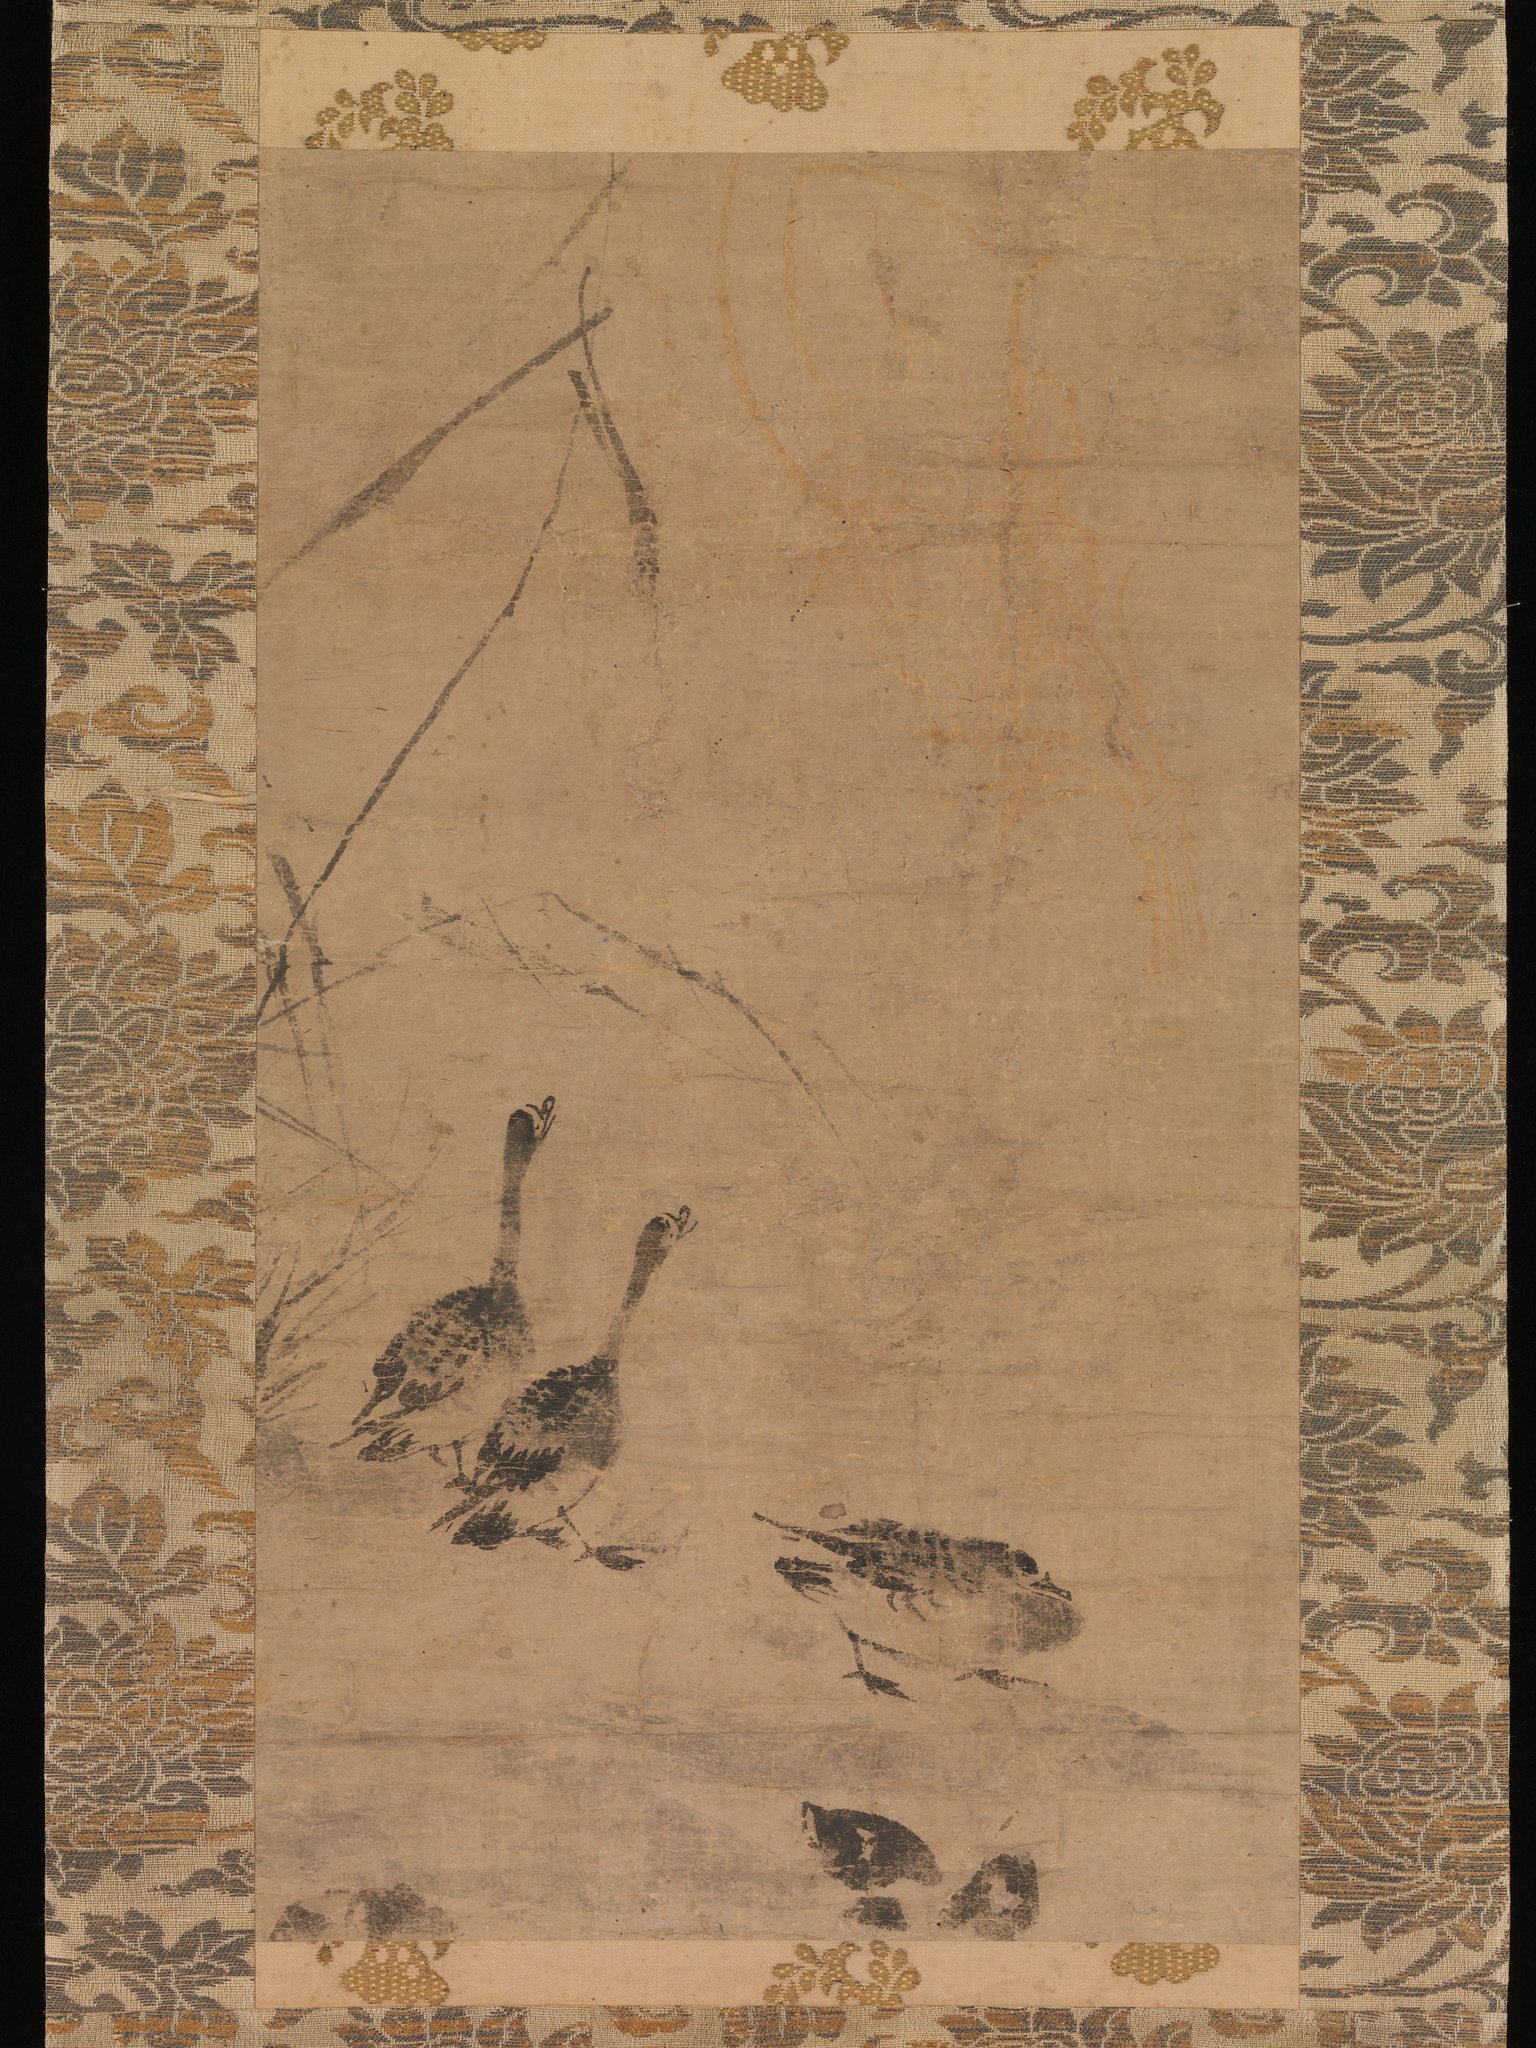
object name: hanging scroll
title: Geese and Reeds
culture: japanese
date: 1367-1400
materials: ink, paper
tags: geese